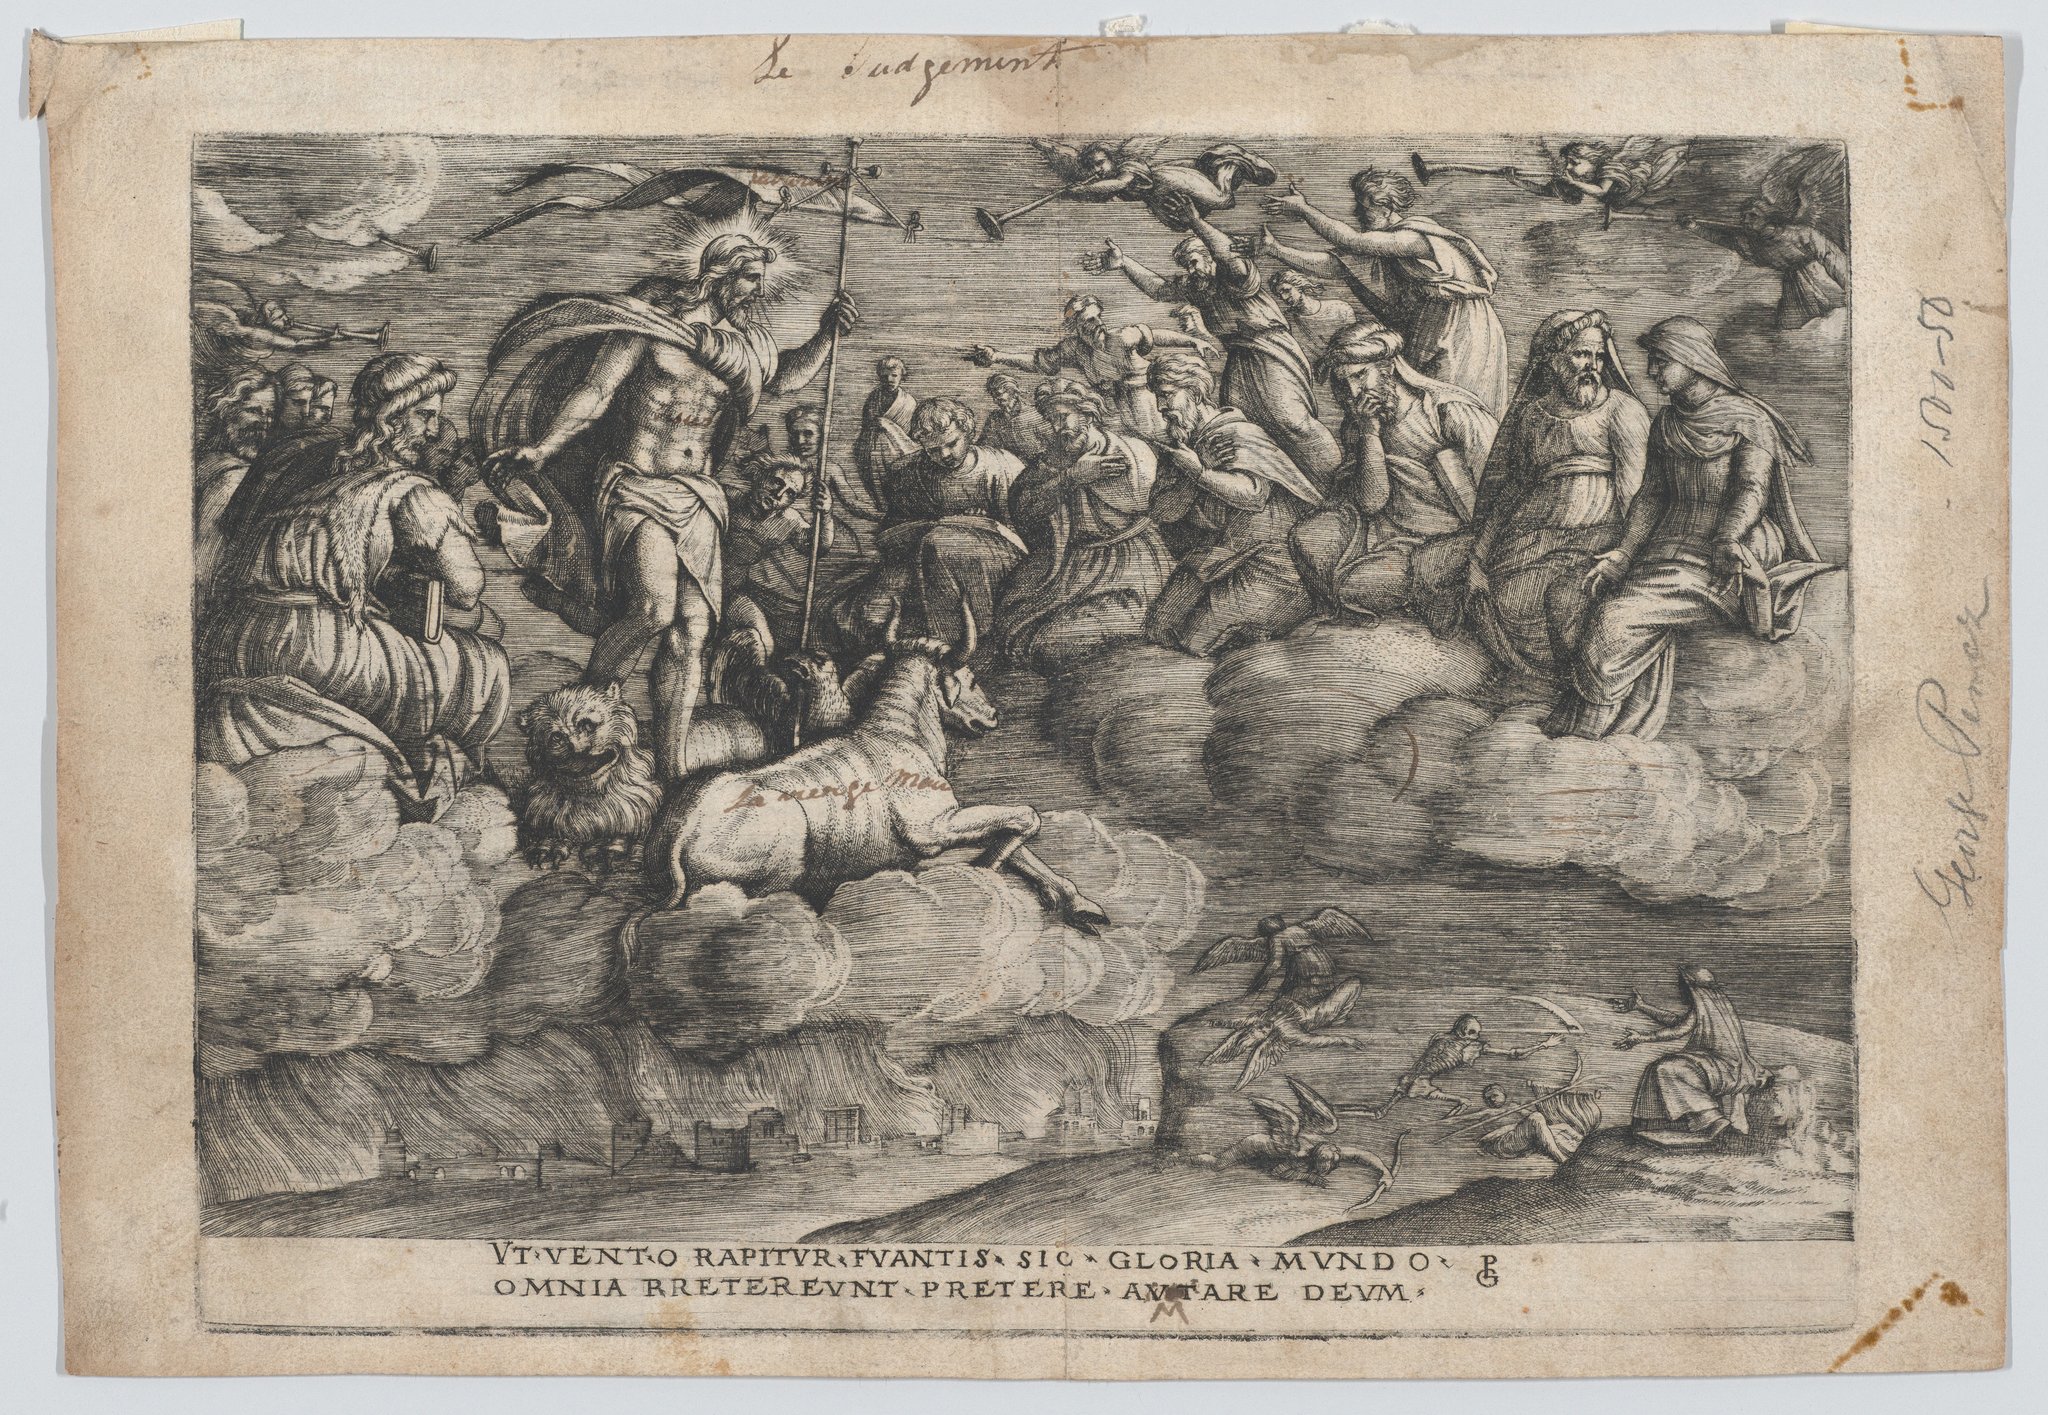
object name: print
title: The Triumph of Eternity on Death, from "The Triumphs of Petrarch"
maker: georg pencz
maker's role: artist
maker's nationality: german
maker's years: 1500-1550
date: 1534-1544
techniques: engraving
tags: skeletons,men,bulls,lions,christ